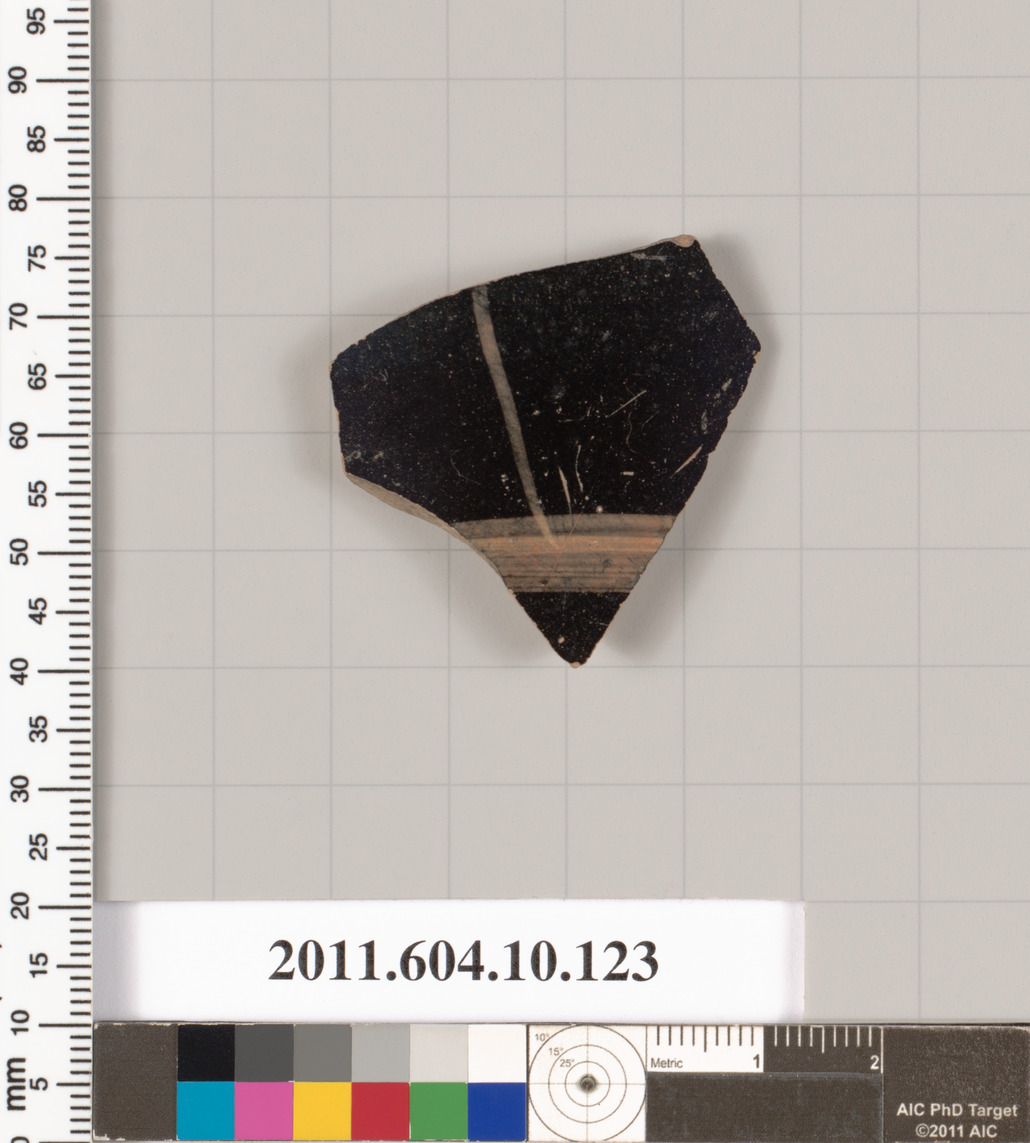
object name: undetermined closed shape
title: Terracotta fragment of a closed shape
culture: etruscan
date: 434-401 BCE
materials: terracotta